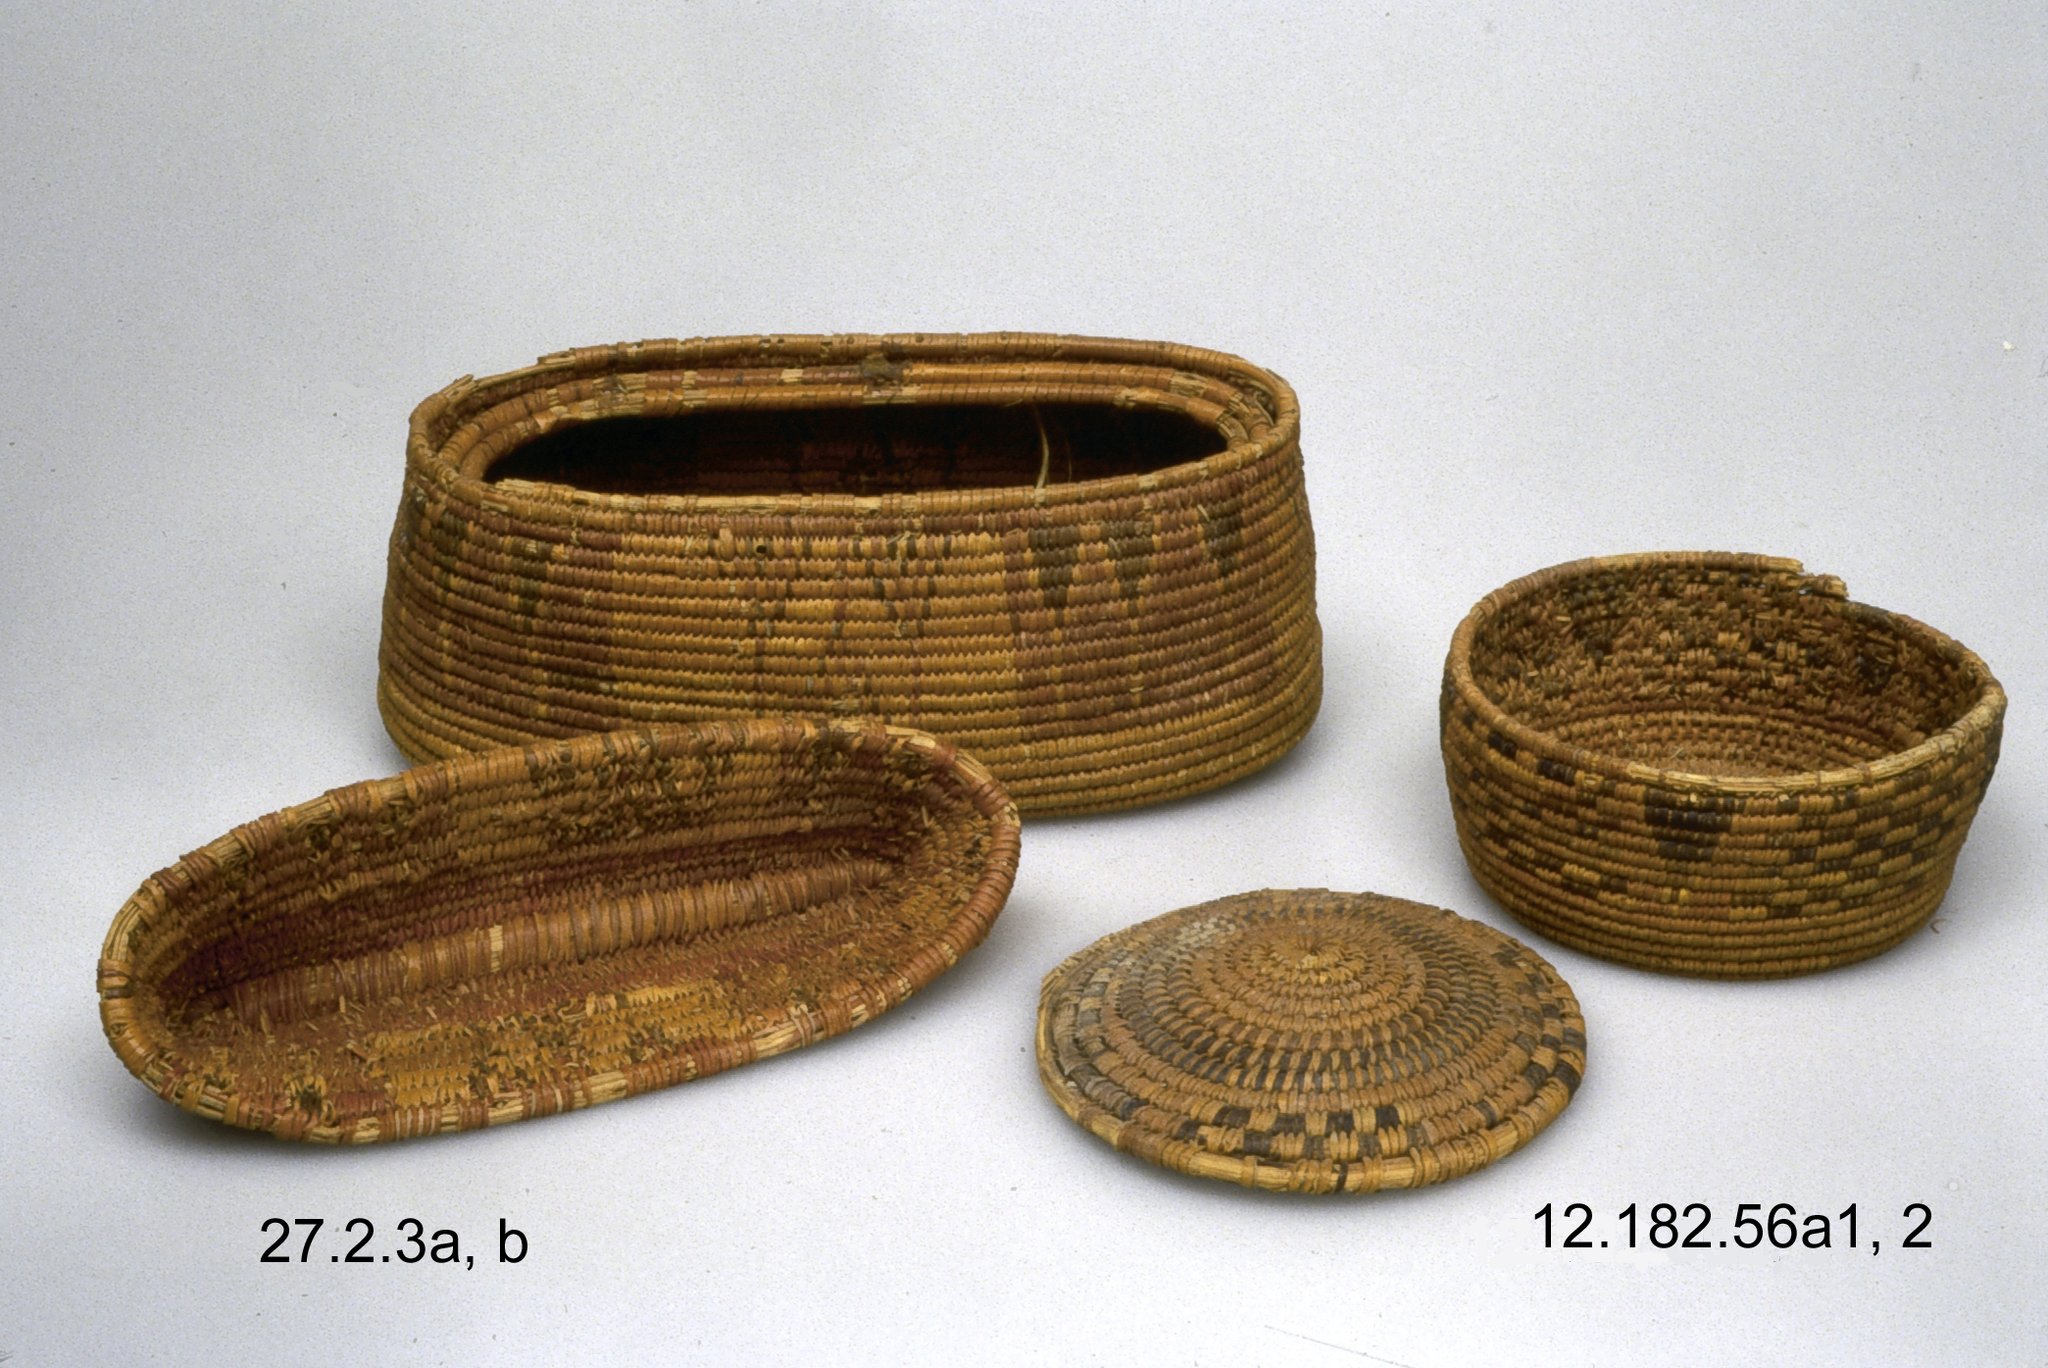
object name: basket, oblong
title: Oblong Basket with Lid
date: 1550-1295 BCE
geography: egypt